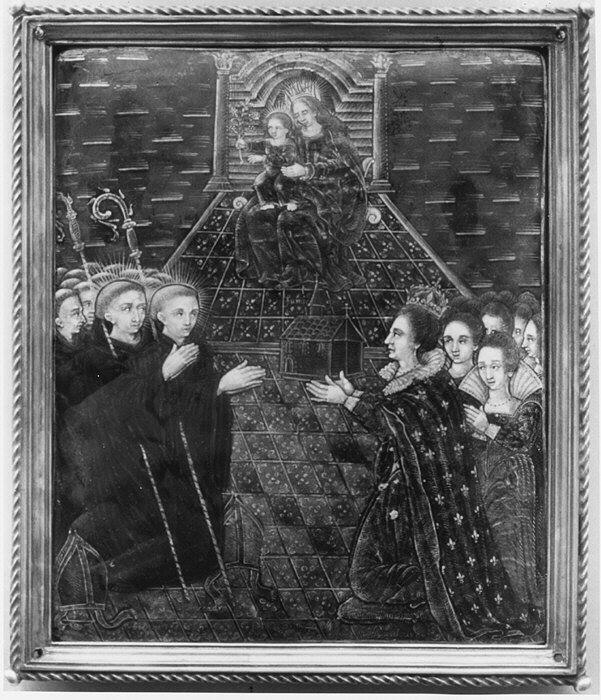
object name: plaque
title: The Devotion of St. Bathilda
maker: jean limosin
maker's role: enameler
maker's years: 1615-1635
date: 1601-1625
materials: copper, enamel, gilt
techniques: painting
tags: madonna and child,saints